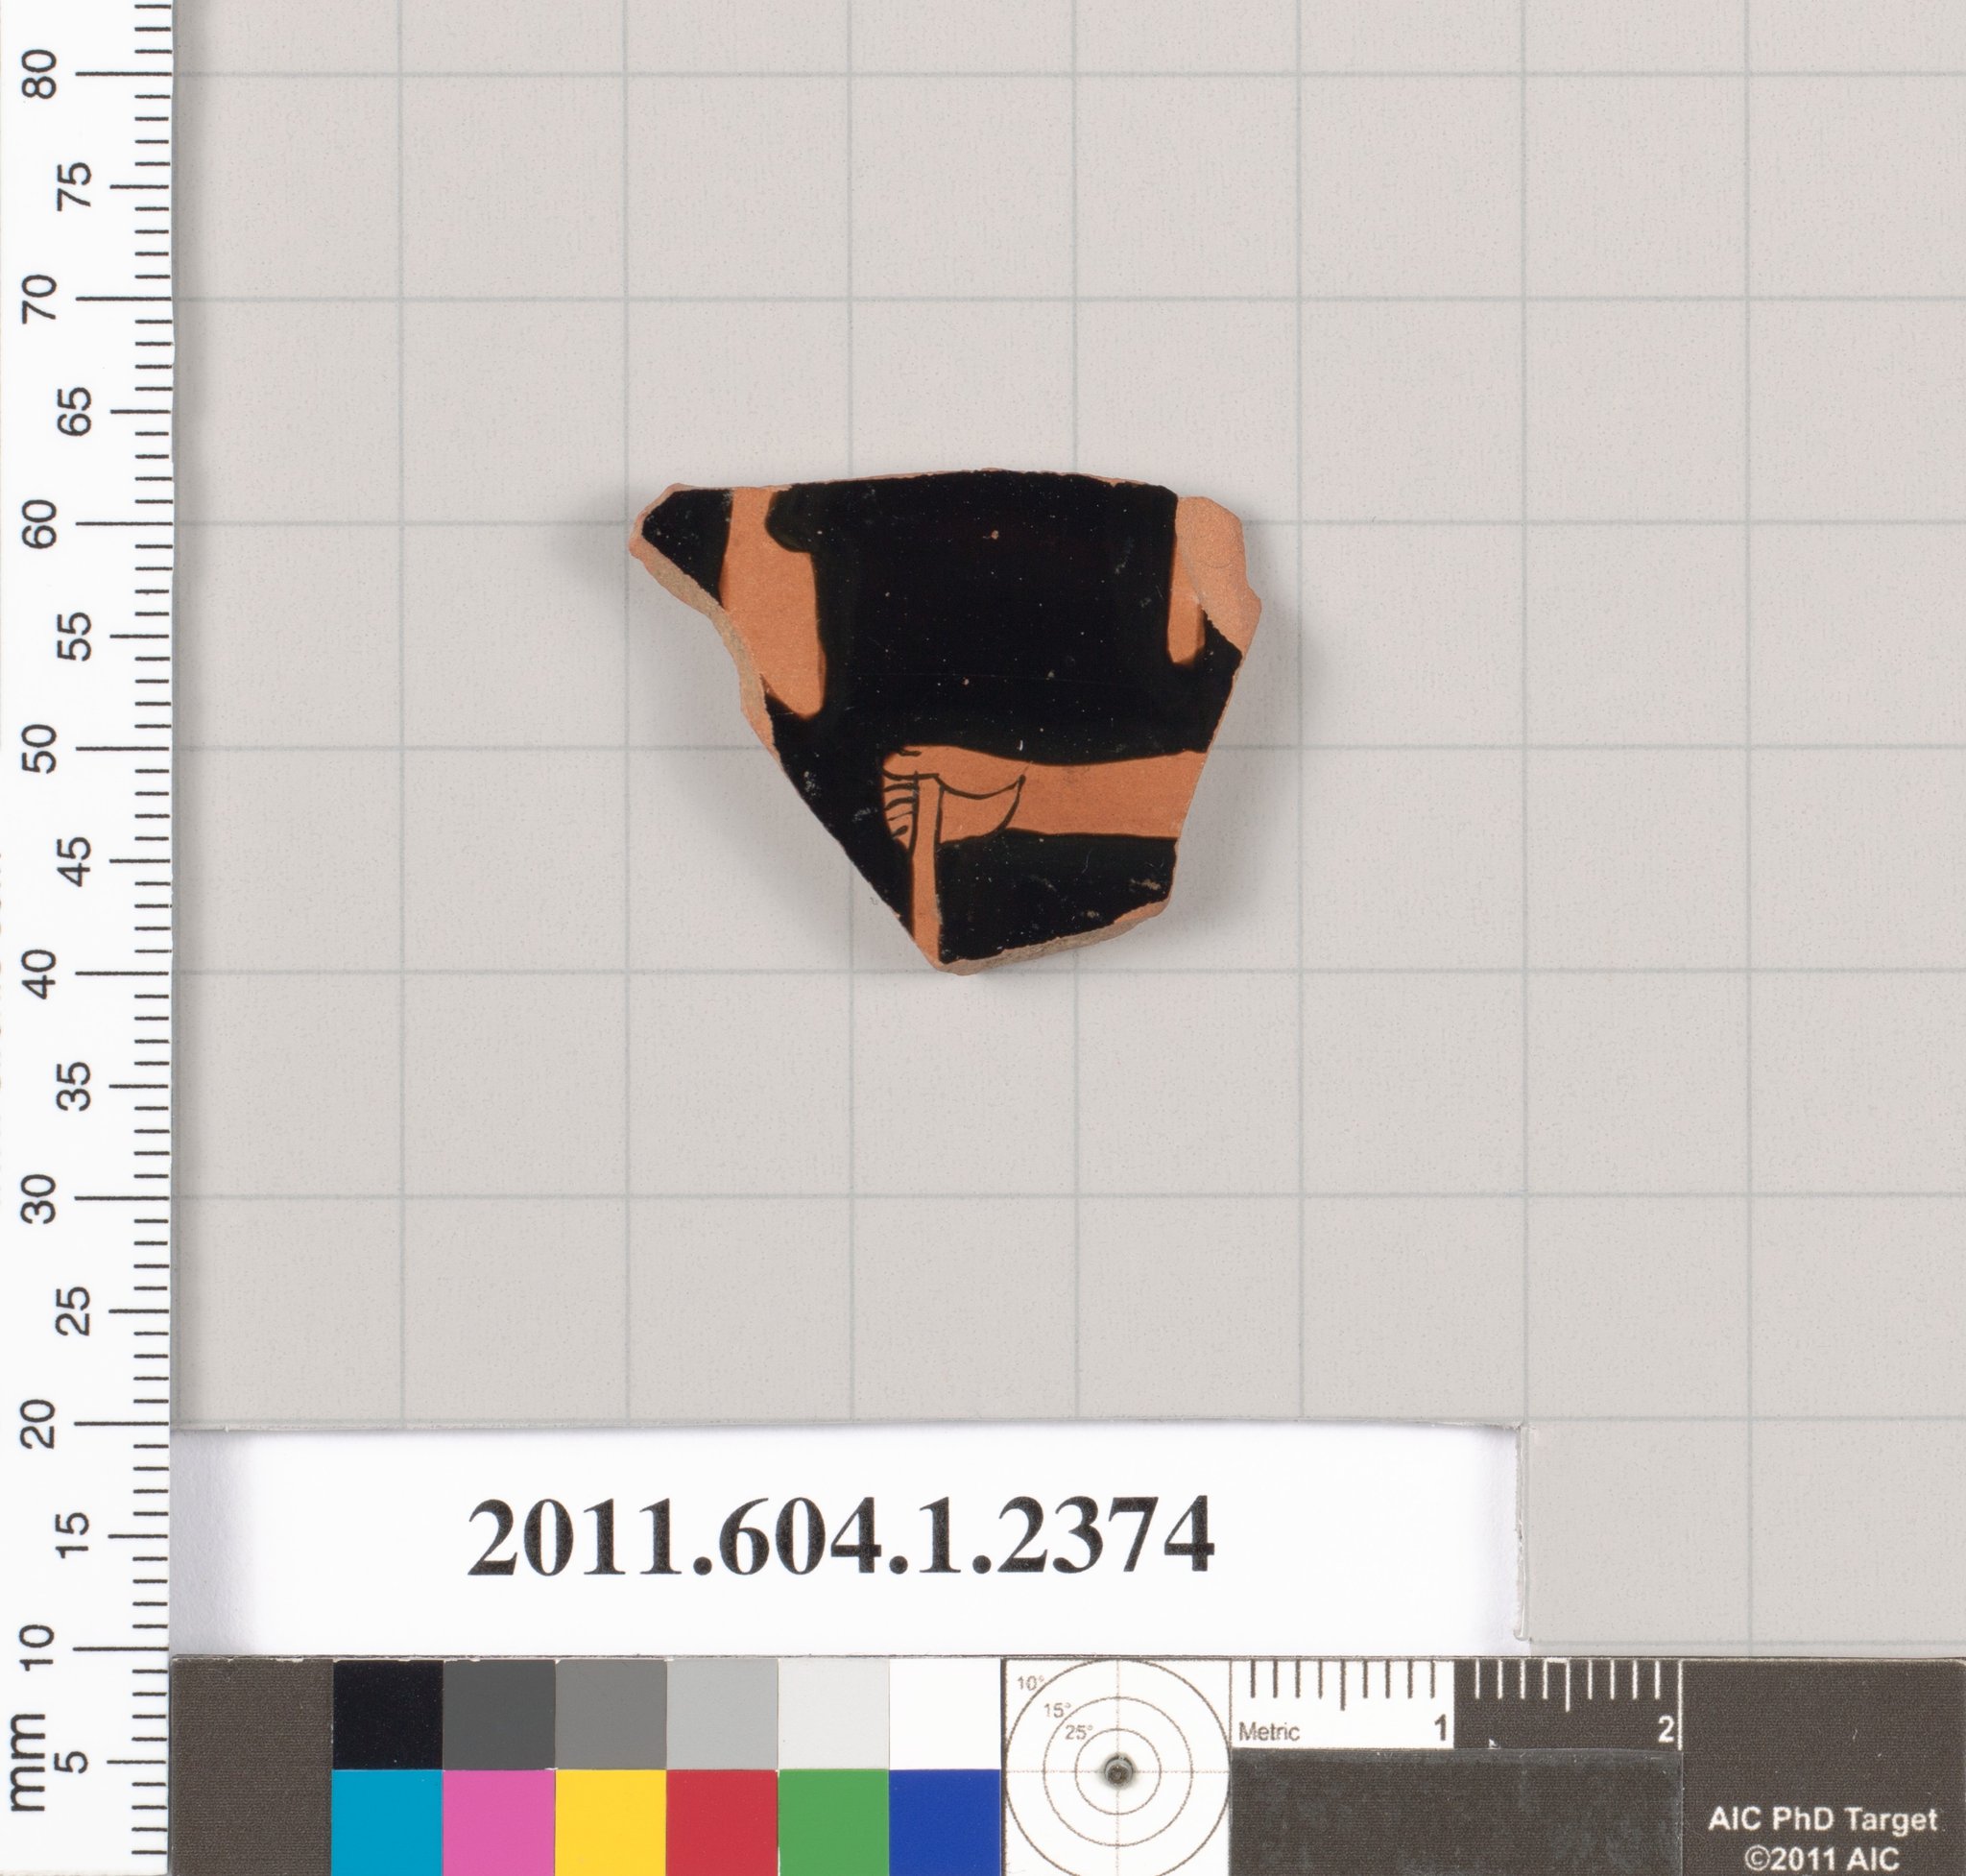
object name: kylix fragment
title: Terracotta fragment of a kylix (drinking cup)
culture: greek, attic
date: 475-451 BCE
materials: terracotta